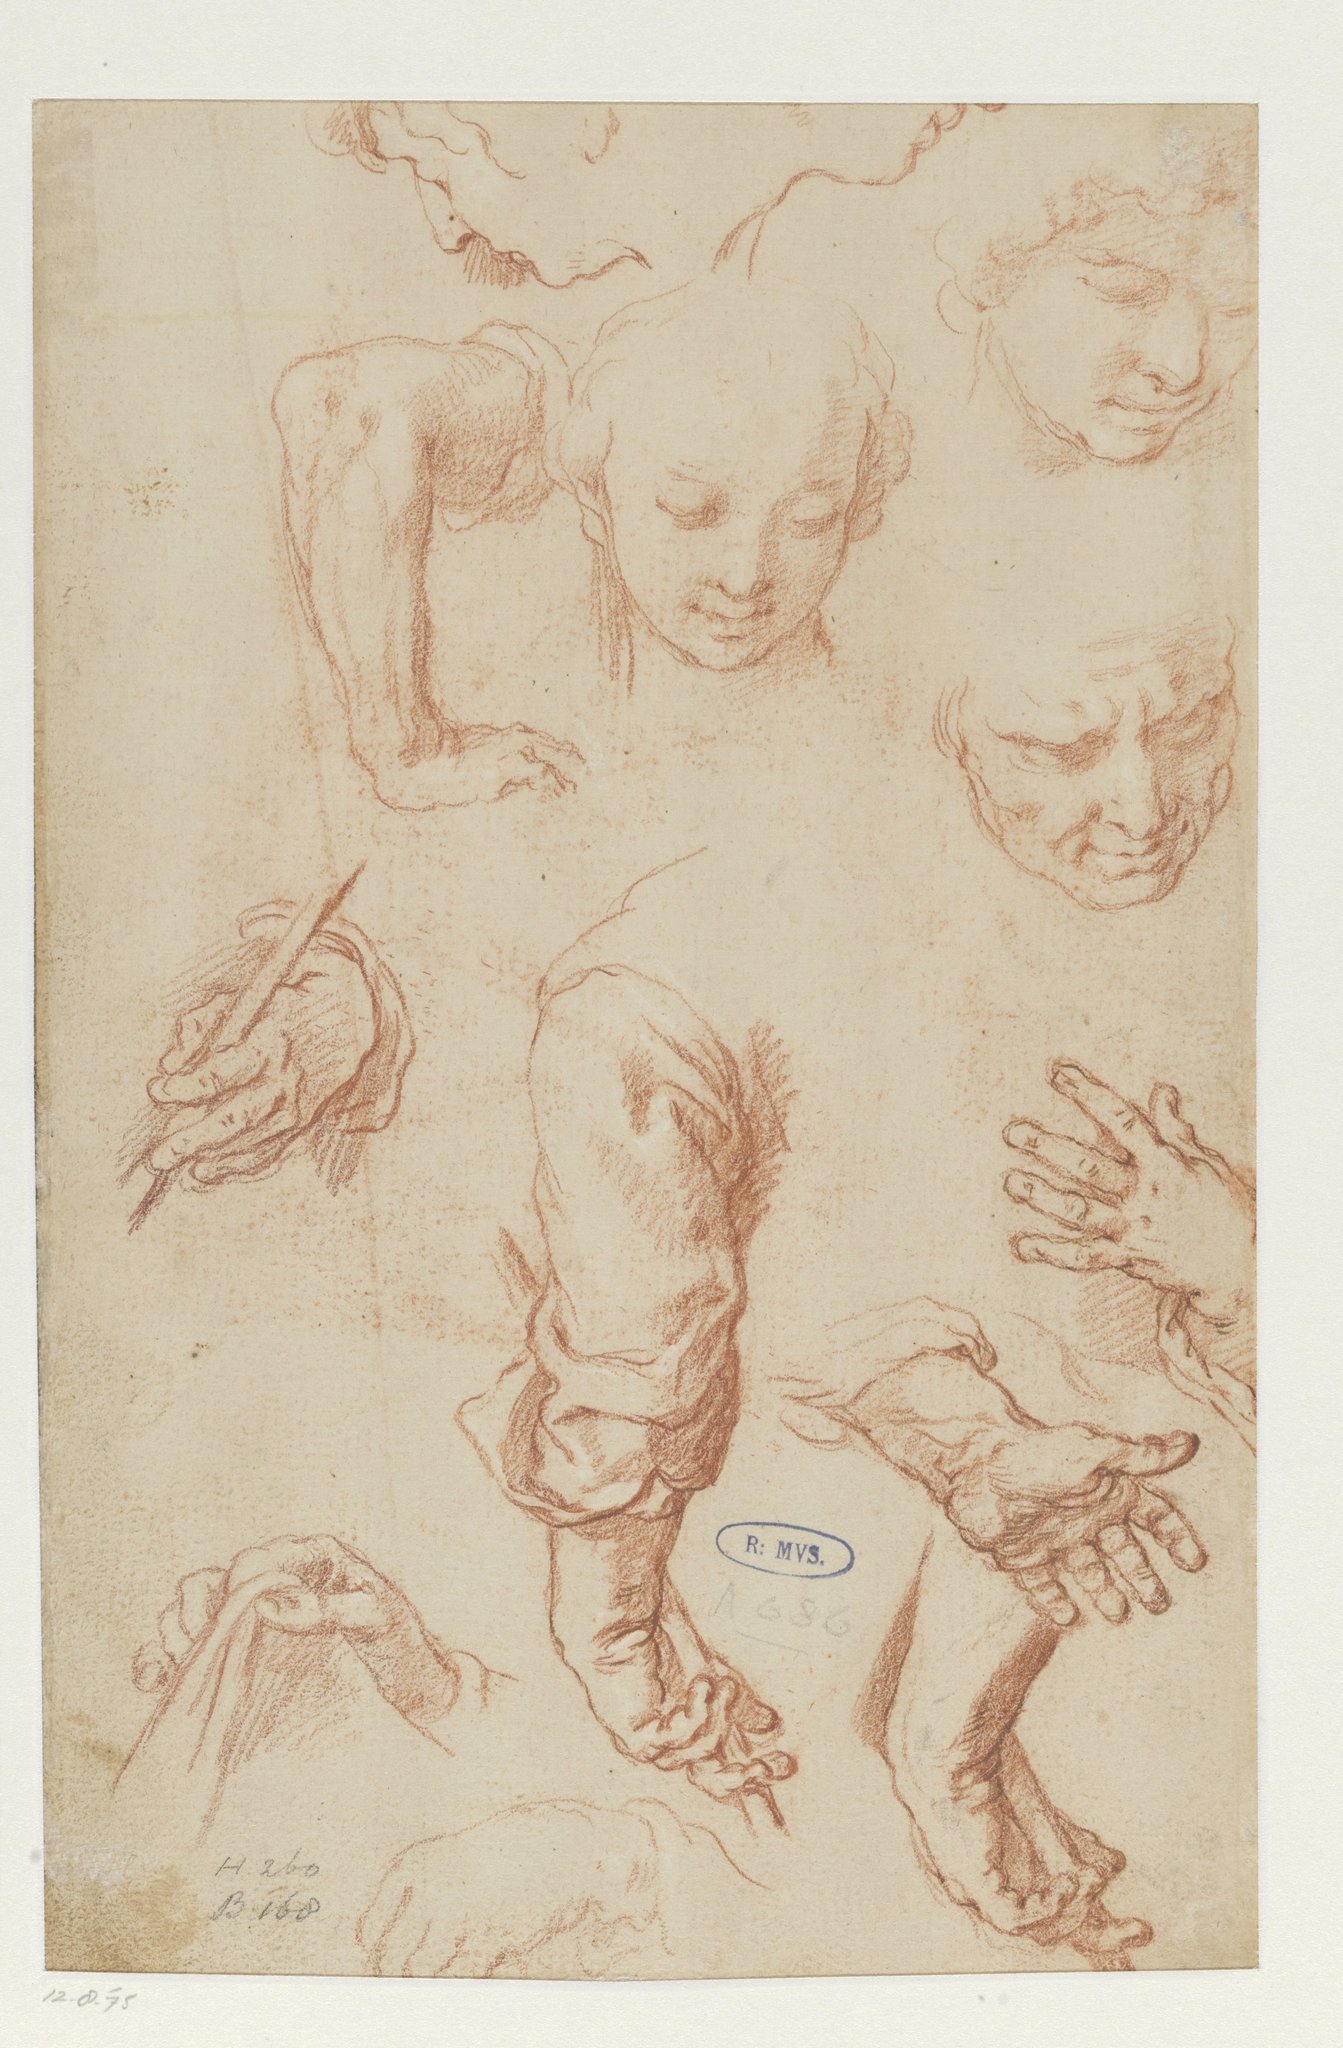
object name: drawing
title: Studies of Arms, Hands and Heads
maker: abraham bloemaert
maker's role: draughtsman, painter, print maker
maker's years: 1566-1651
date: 1574-1651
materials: chalk, paper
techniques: pen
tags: head (human), arms, hand